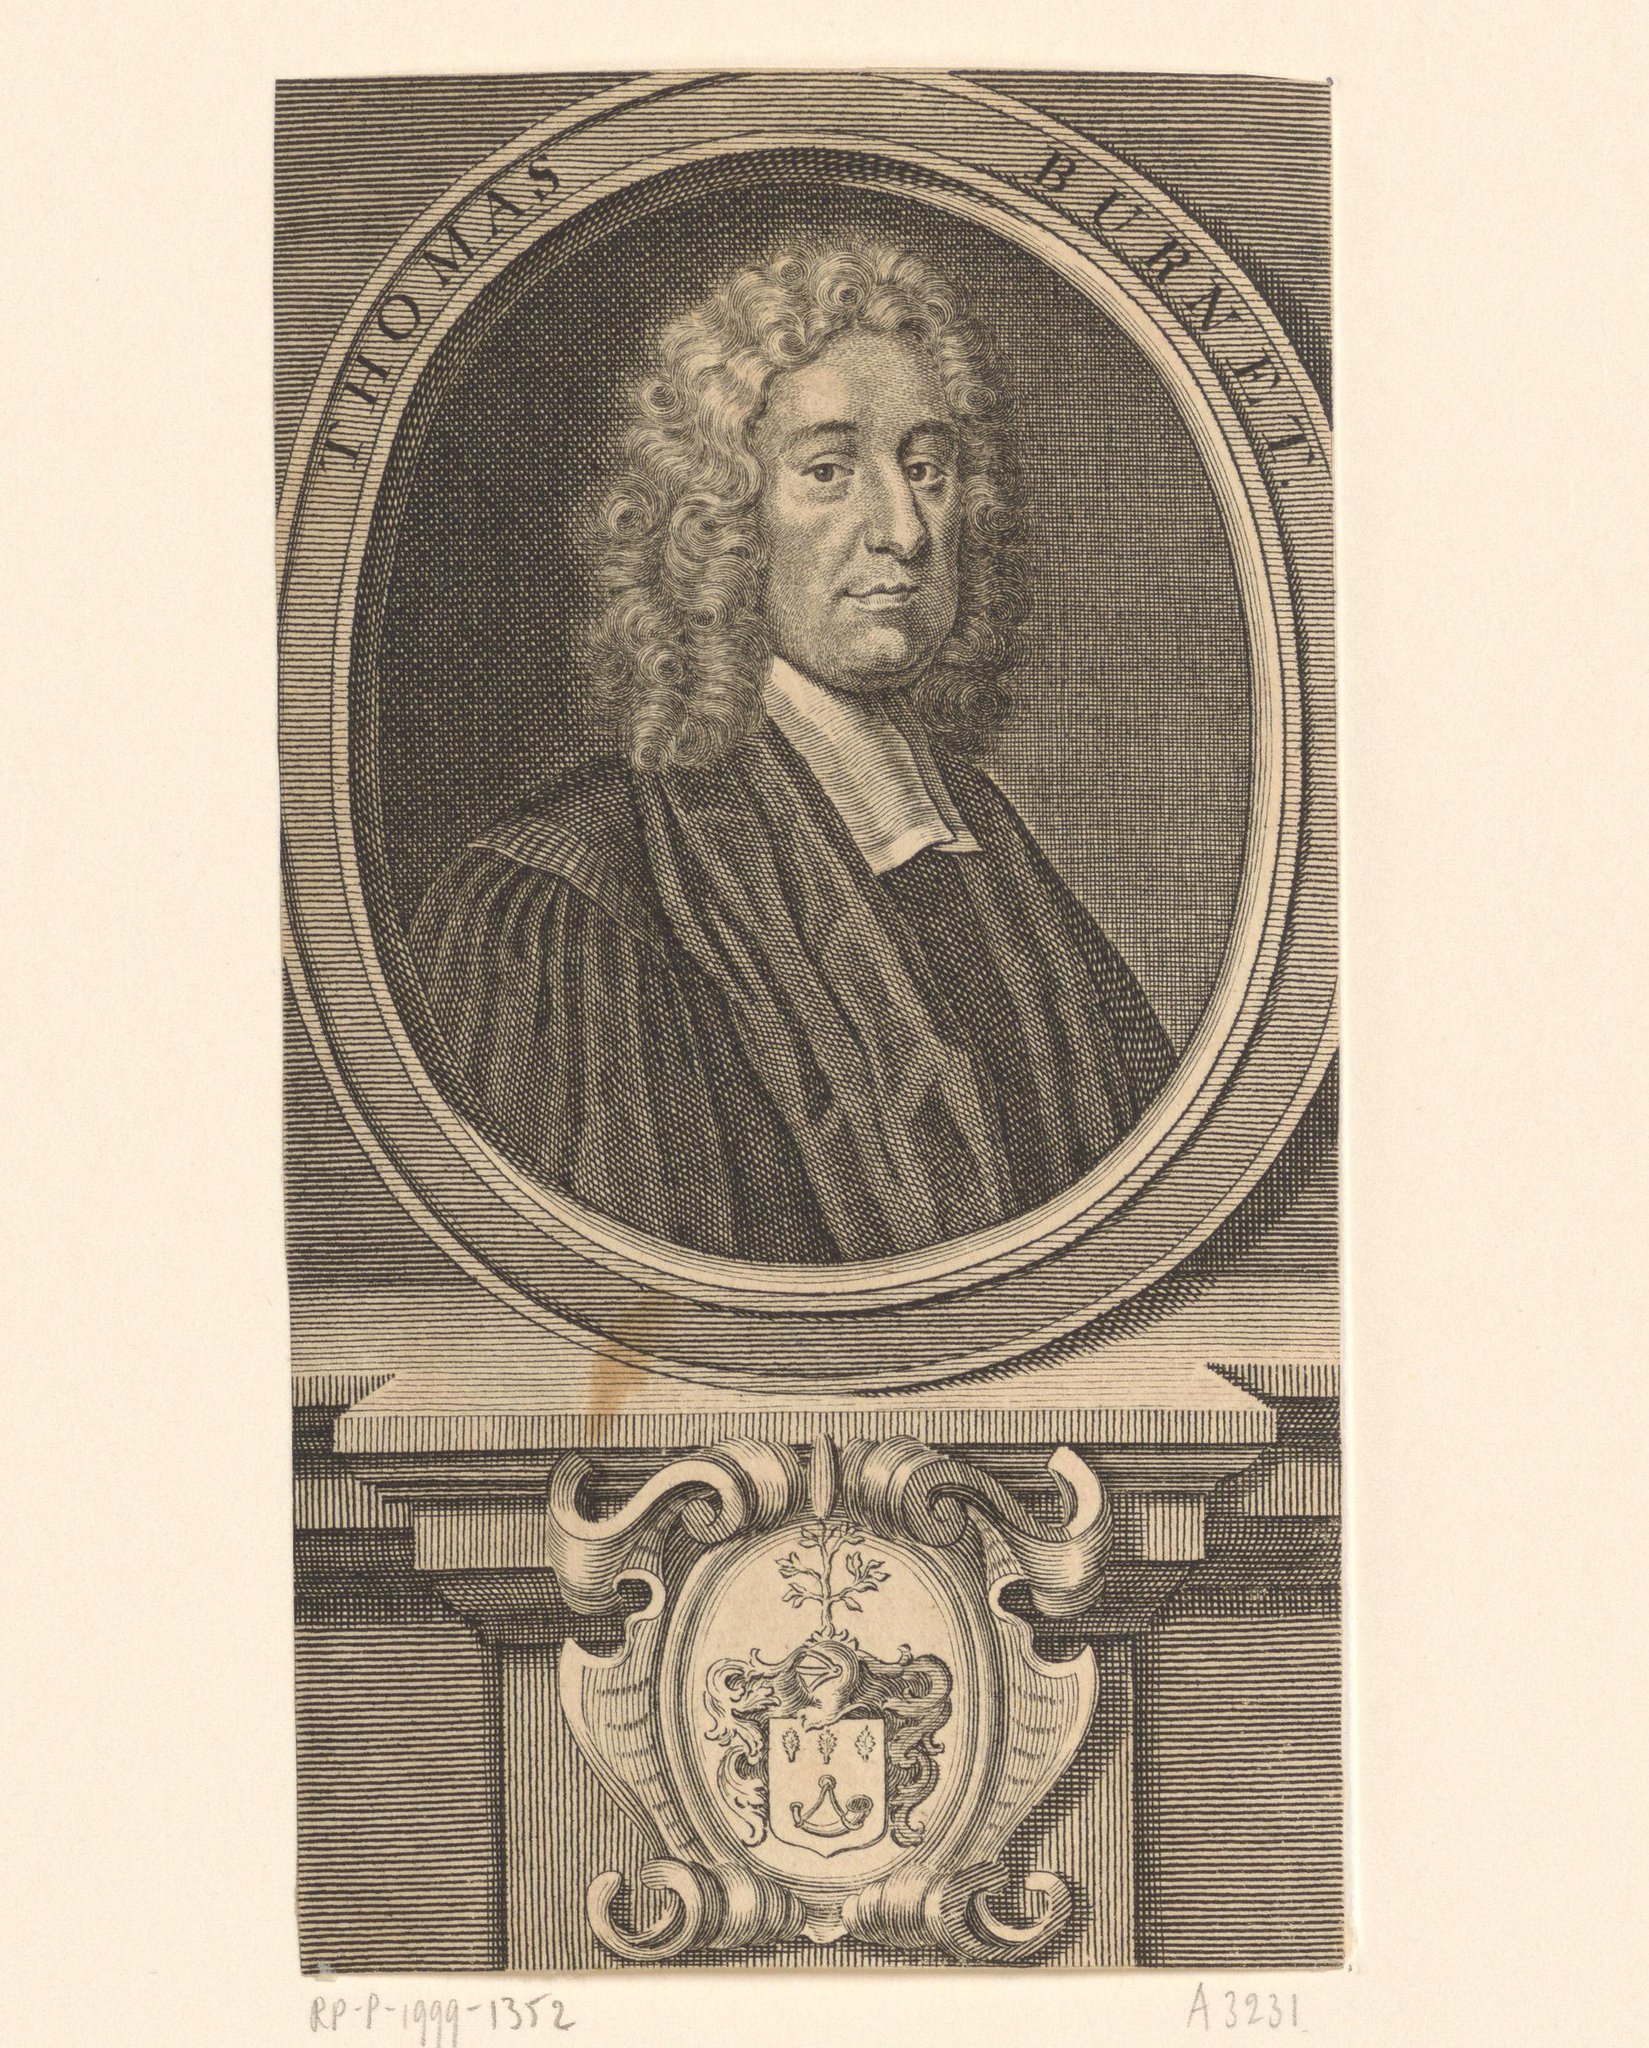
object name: print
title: Portret van Thomas Burnet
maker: Anonymous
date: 1675-1724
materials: paper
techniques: engraving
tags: theologian, historical persons, armorial bearing, heraldry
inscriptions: collector's mark: Lugt 2760, collector's mark: Lugt 2228